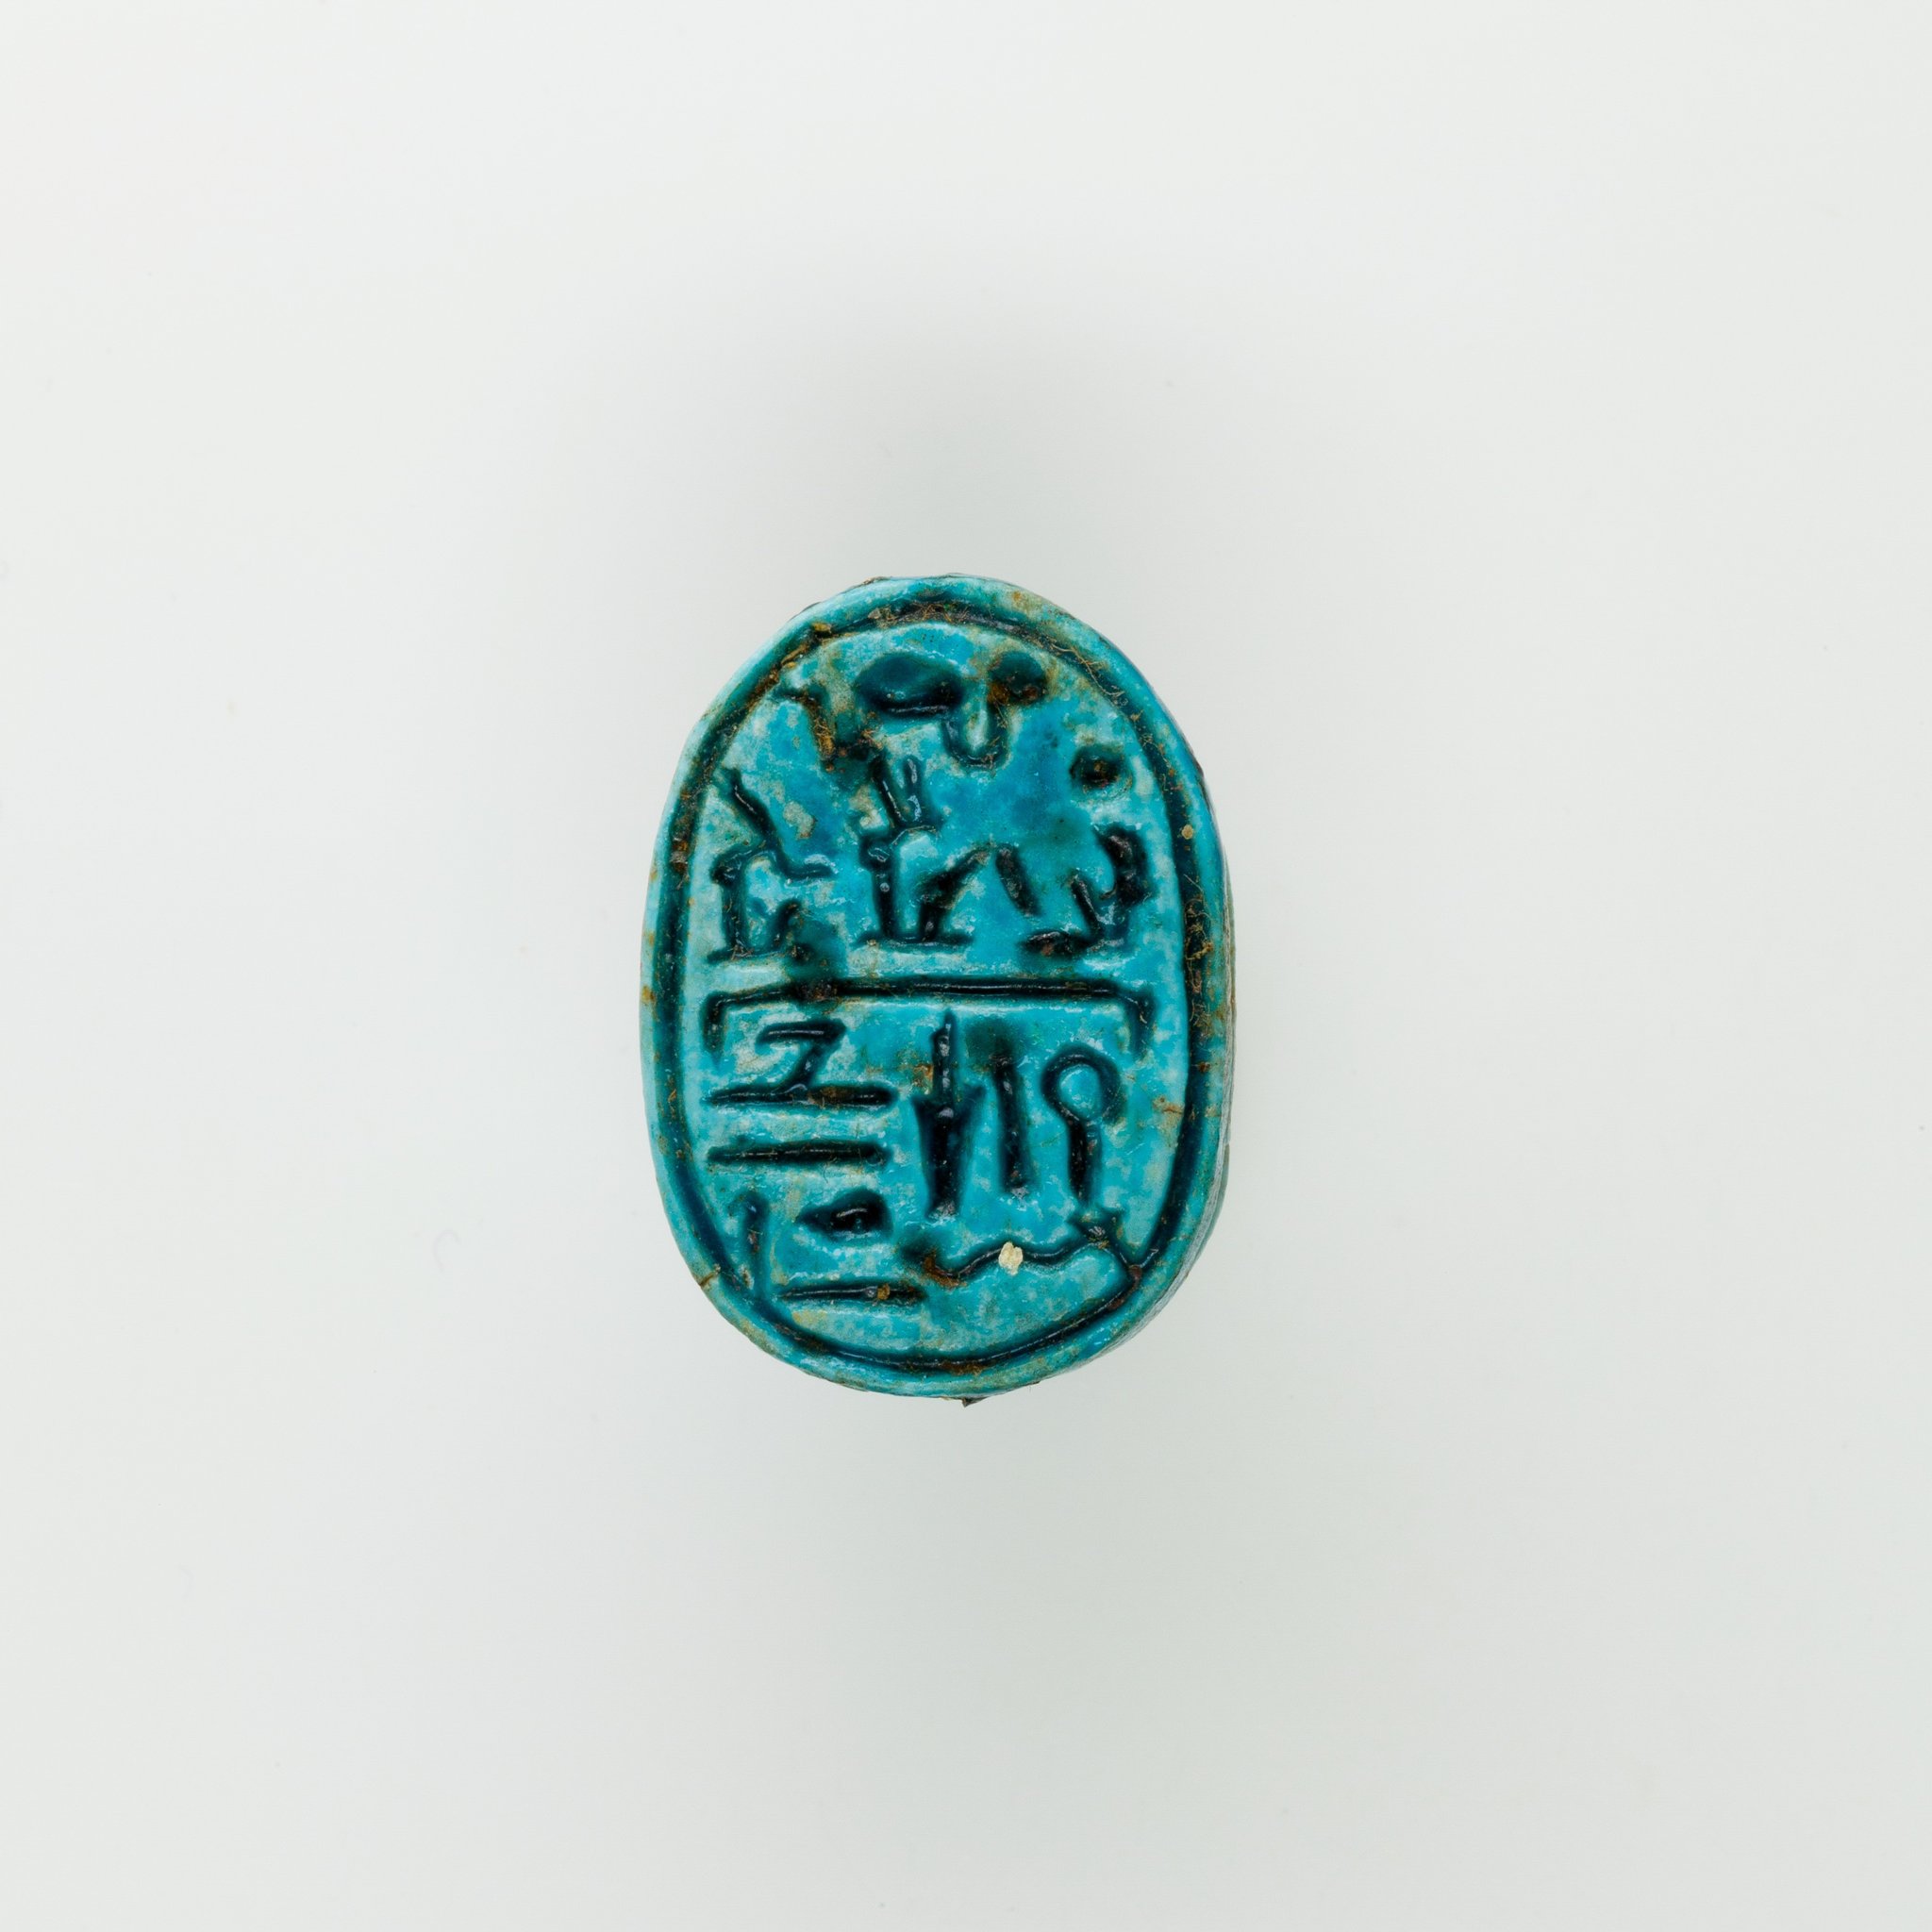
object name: scarab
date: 1295-1070 BCE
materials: stone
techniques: glazing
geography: egypt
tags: scarabs